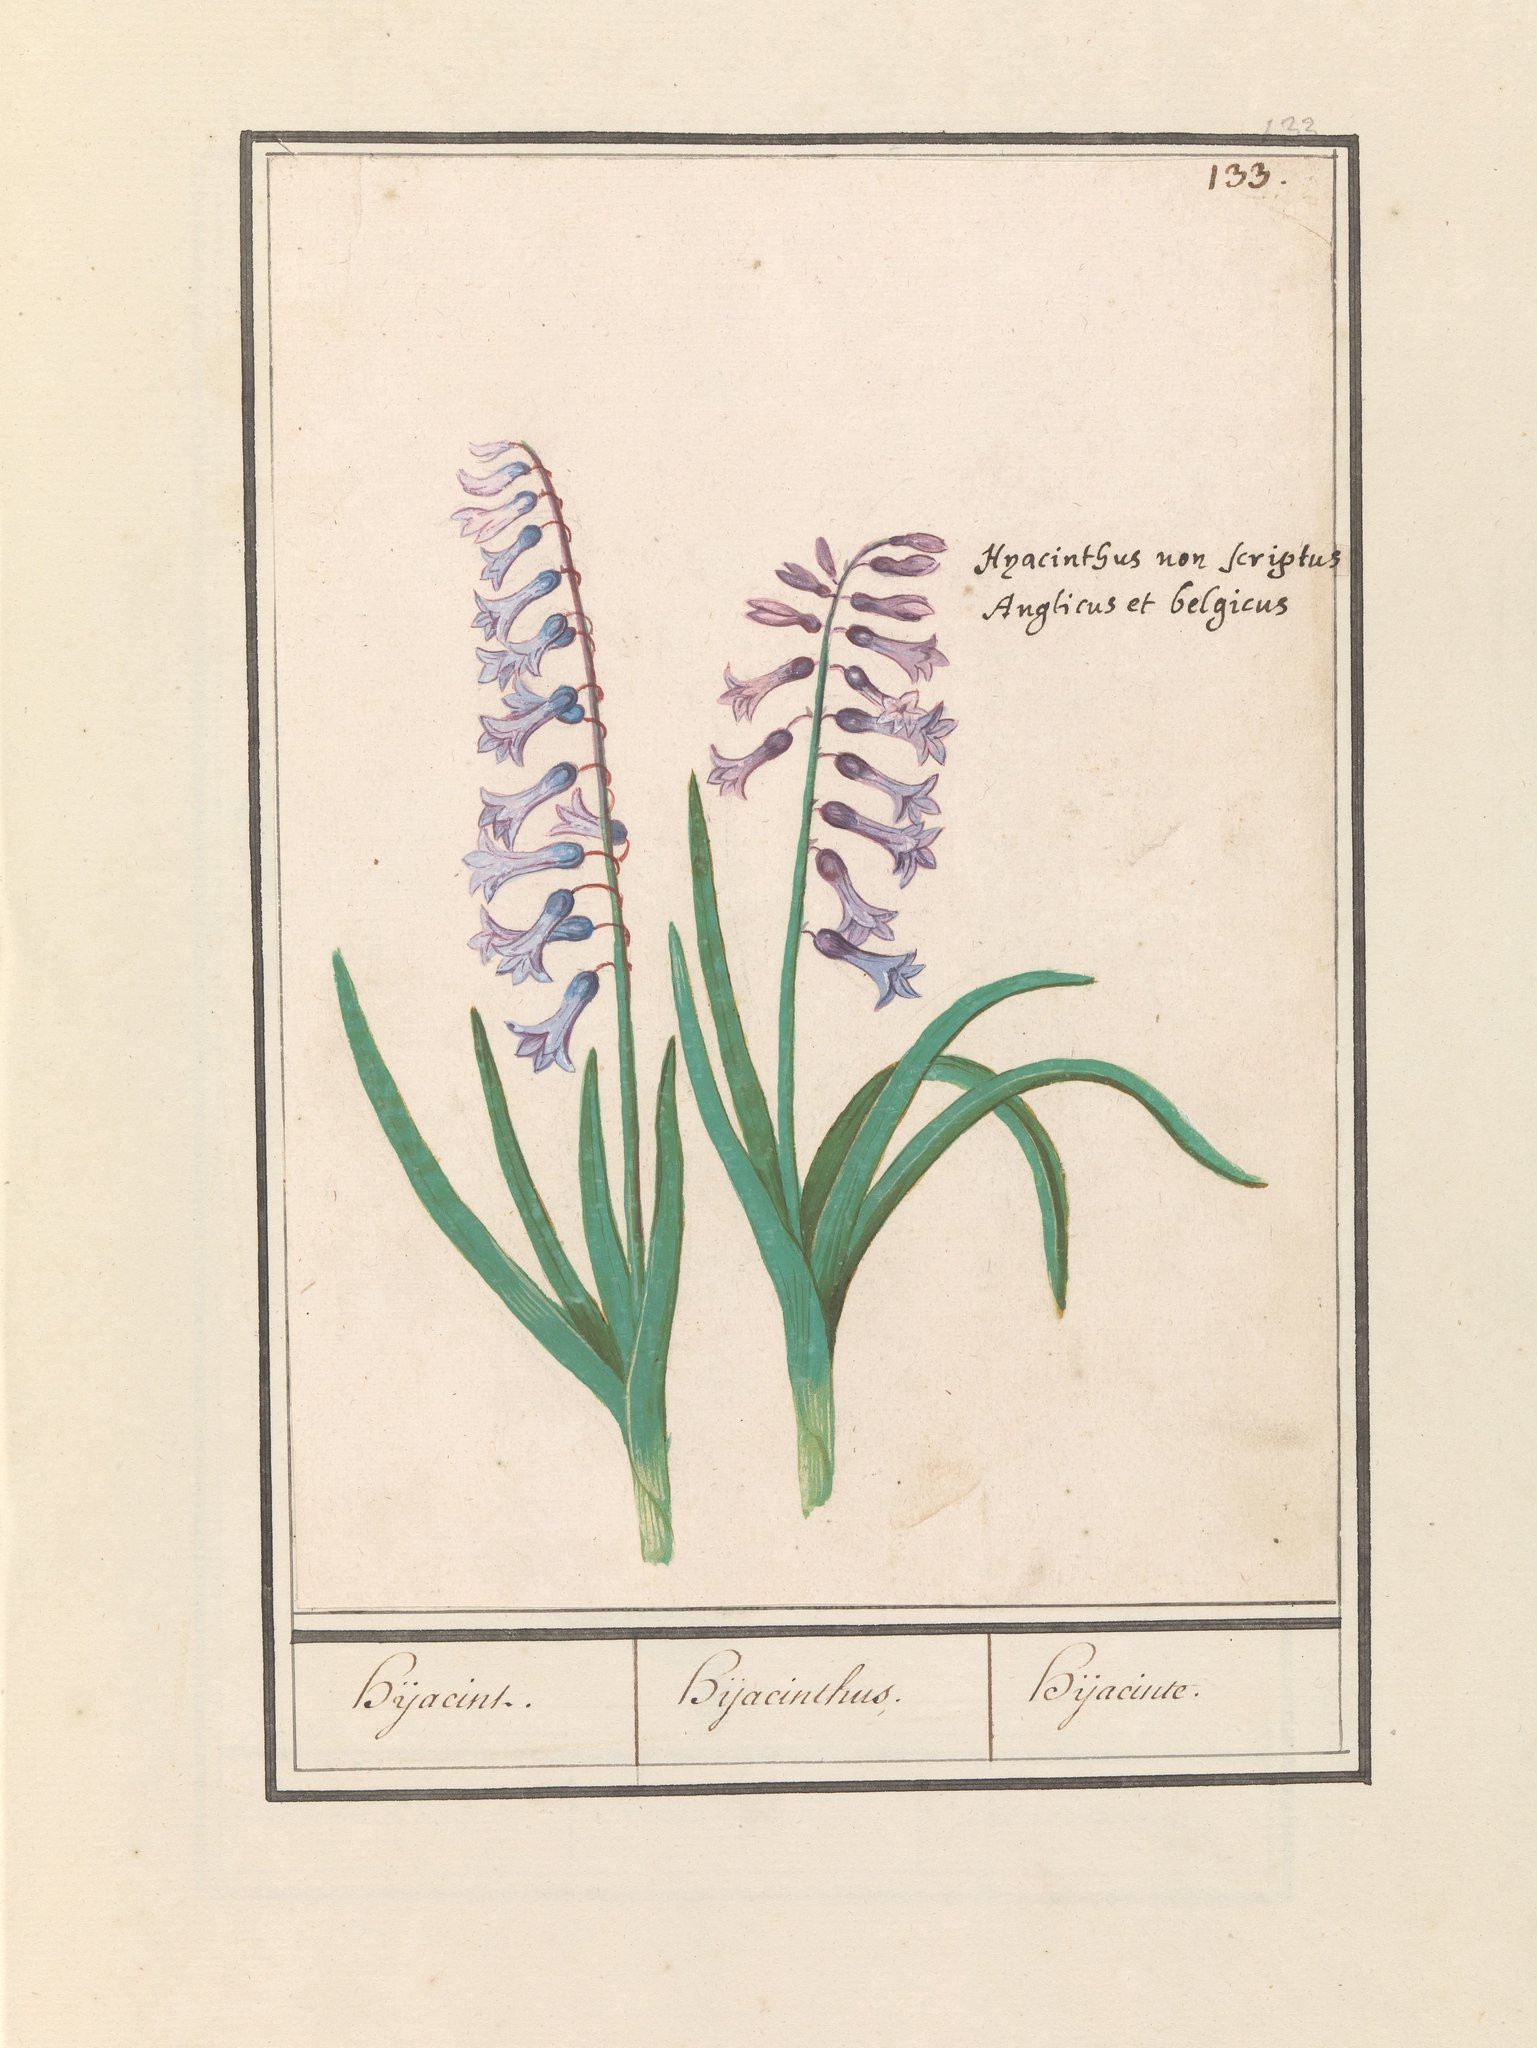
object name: drawing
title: Hyacint (Hyacinthus orientalis)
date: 1596-1610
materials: chalk, paint, ink, paper, watercolor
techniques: brush, pen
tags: flowers: hyacinth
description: Blauwe hyacint. Rechtsboven genummerd: 133. Rechtsboven de Latijnse namen. Onderdeel van het tweede album met tekeningen van bloemen en planten. Negende van twaalf albums met tekeningen van dieren, vogels en planten bekend rond 1600, gemaakt in opdracht van keizer Rudolf II. Met toelichting in Nederlands, Latijn en Frans.